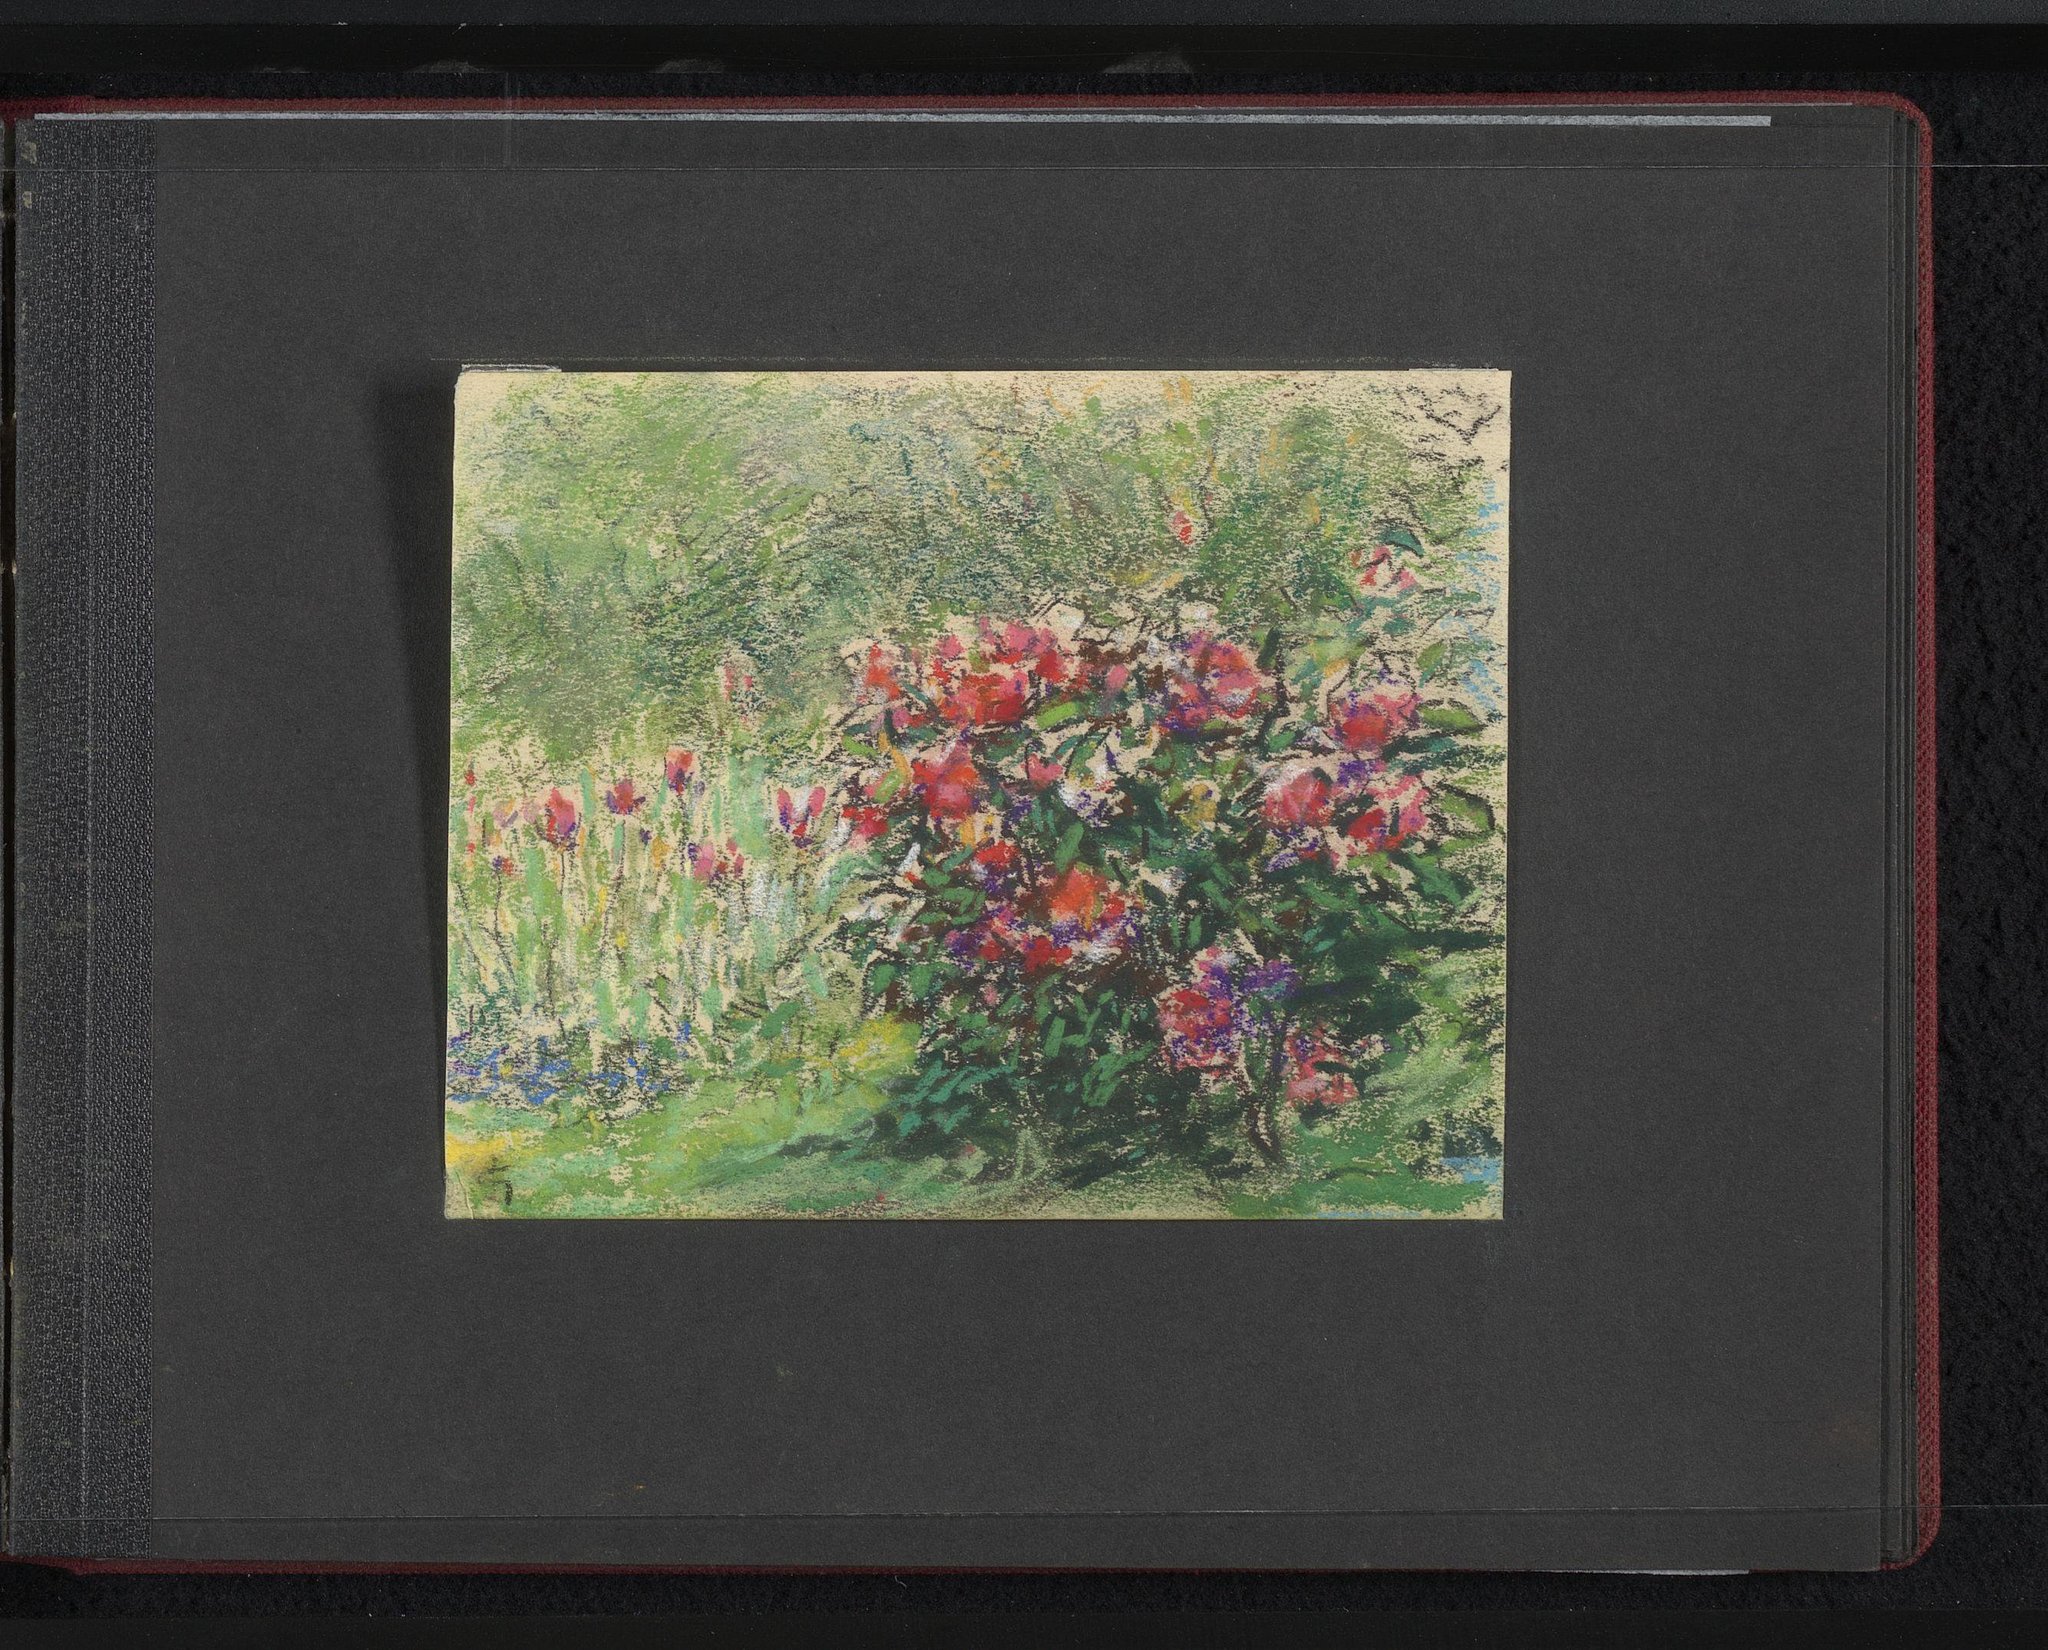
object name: album leaf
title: Bloemen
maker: carel nicolaas storm van s-gravesande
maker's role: draughtsman, print maker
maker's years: 1841-1924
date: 1915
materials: chalk, paper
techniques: pasting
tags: flowers, public gardens, park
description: Mogelijk in het Kurpark te Wiesbaden. Tekening maakt deel uit van een album.